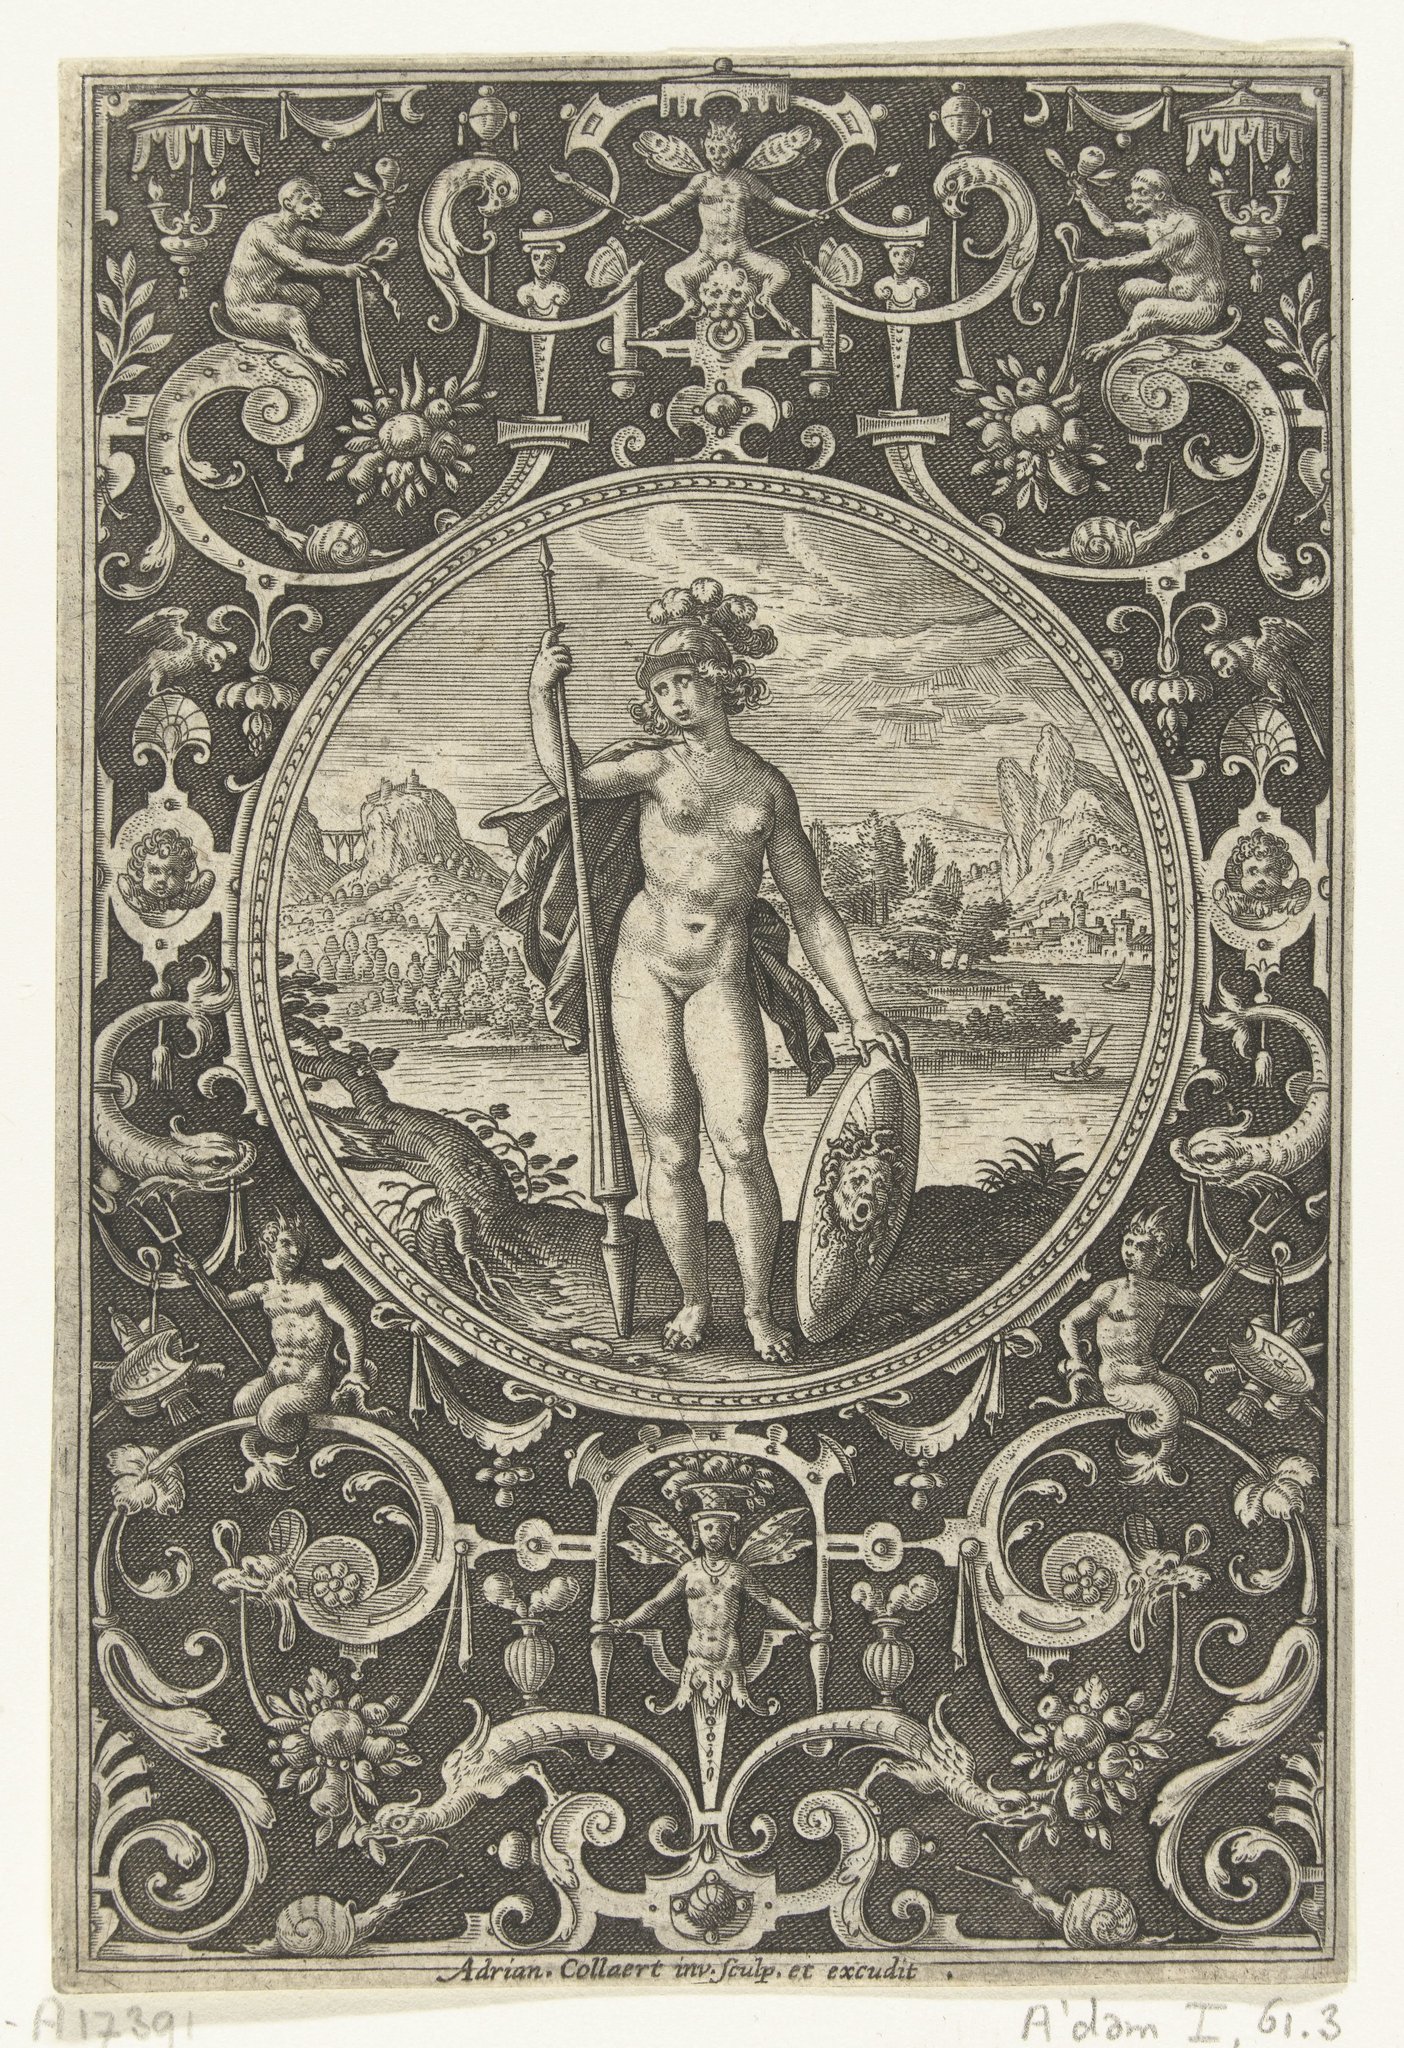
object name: print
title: Mythologische voorstellingen. Suite van 6 stuks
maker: adriaen collaert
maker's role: draughtsman, print maker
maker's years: 1560-1618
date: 1570-1618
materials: paper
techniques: engraving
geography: netherlands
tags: (story of) minerva (pallas, athena)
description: Medaillon in omlijsting van grotesken waarin middenonder een gevleugelde herme met een fruitmand op haar hoofd. Gearceerde achtergrond. Onderdeel van serie van 6 bladen met medaillons in een omlijsting van grotesken met bloemen, guirlandes, dieren en mascarons.